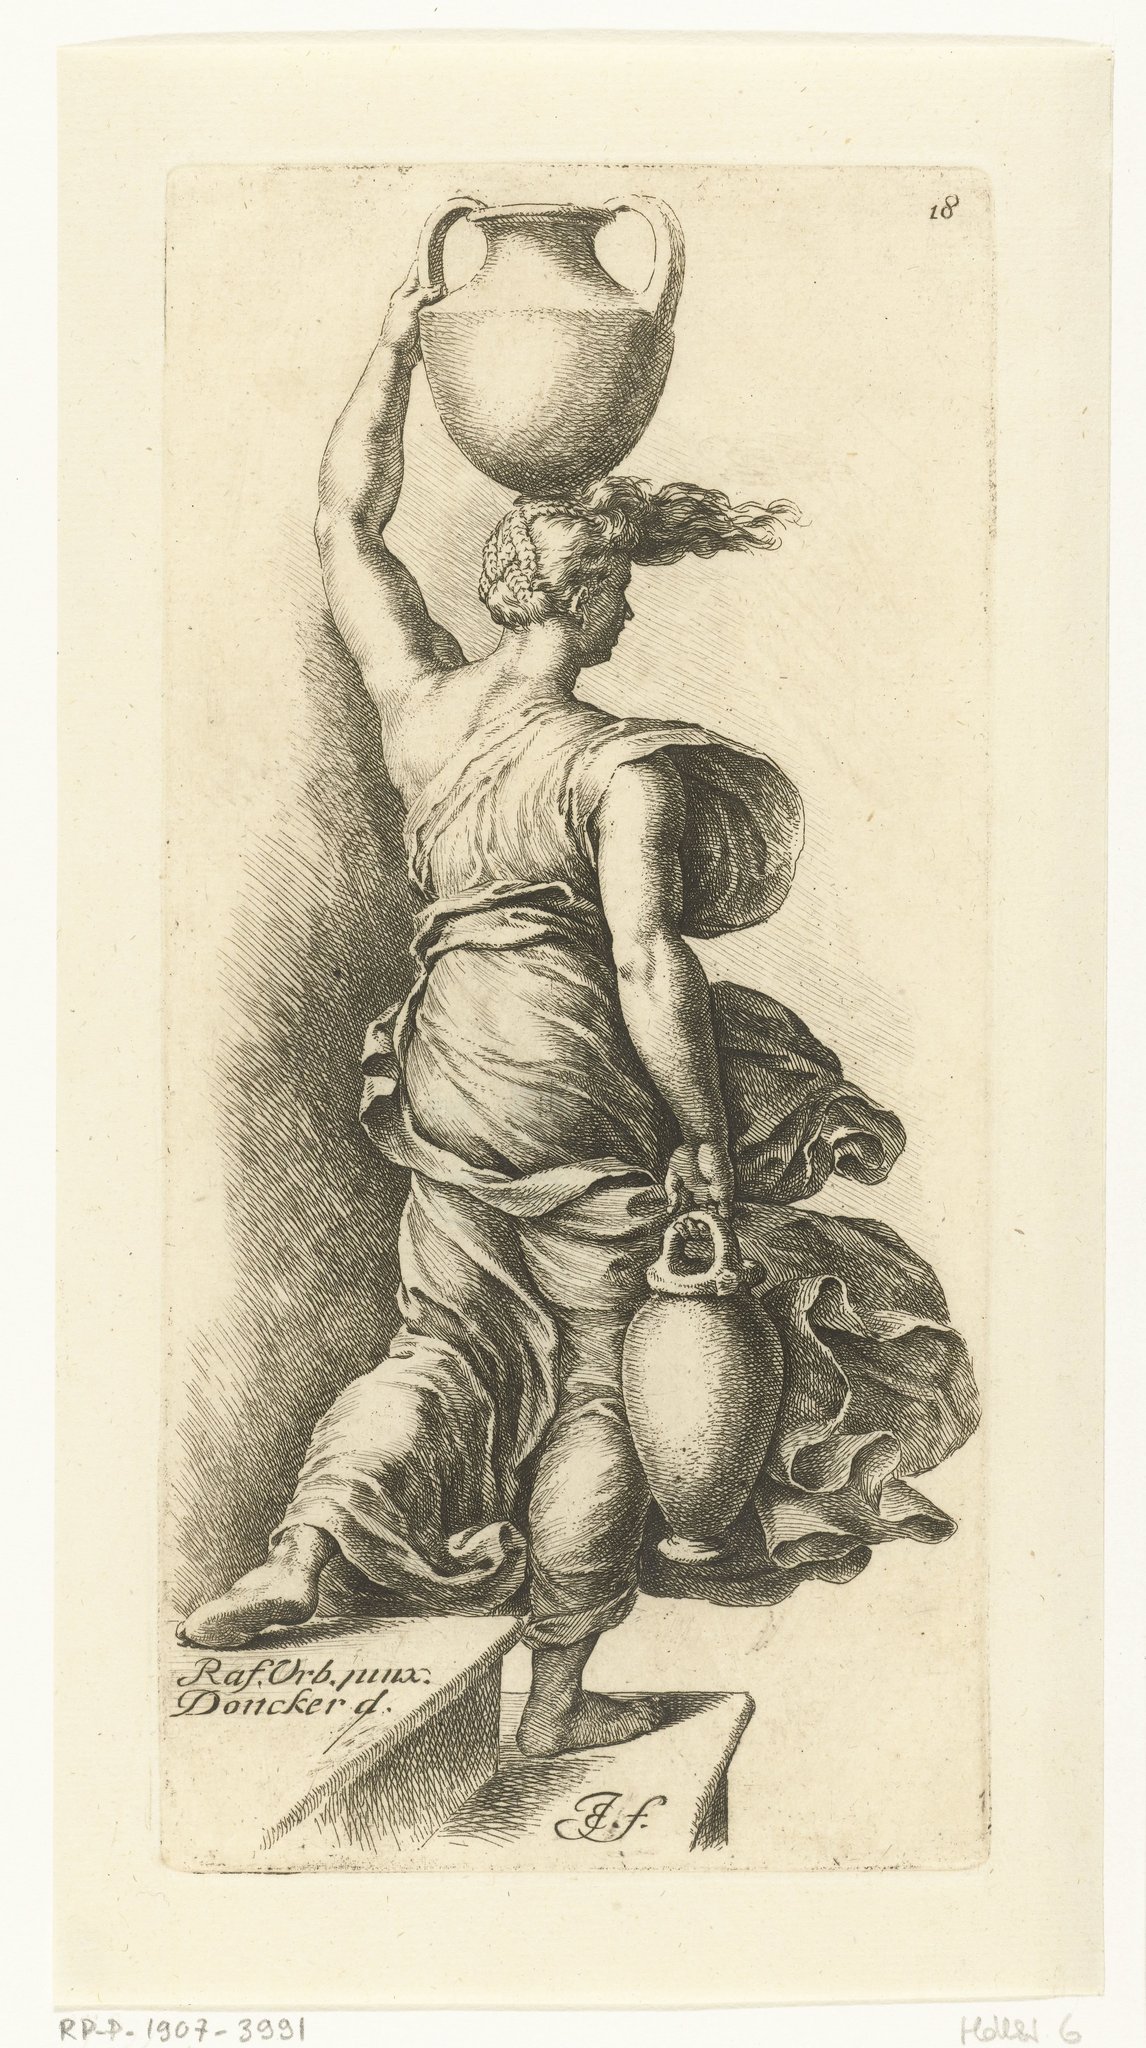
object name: print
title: Vrouw met een kruik op haar hoofd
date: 1668-1671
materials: paper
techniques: etching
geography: northern netherlands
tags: fire-fighting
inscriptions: collector's mark: Lugt 2228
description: Een vrouw met een kruik water op haar hoofd en een tweede kruik in haar hand loopt een trap af om te helpen bij het blussen van een brand.